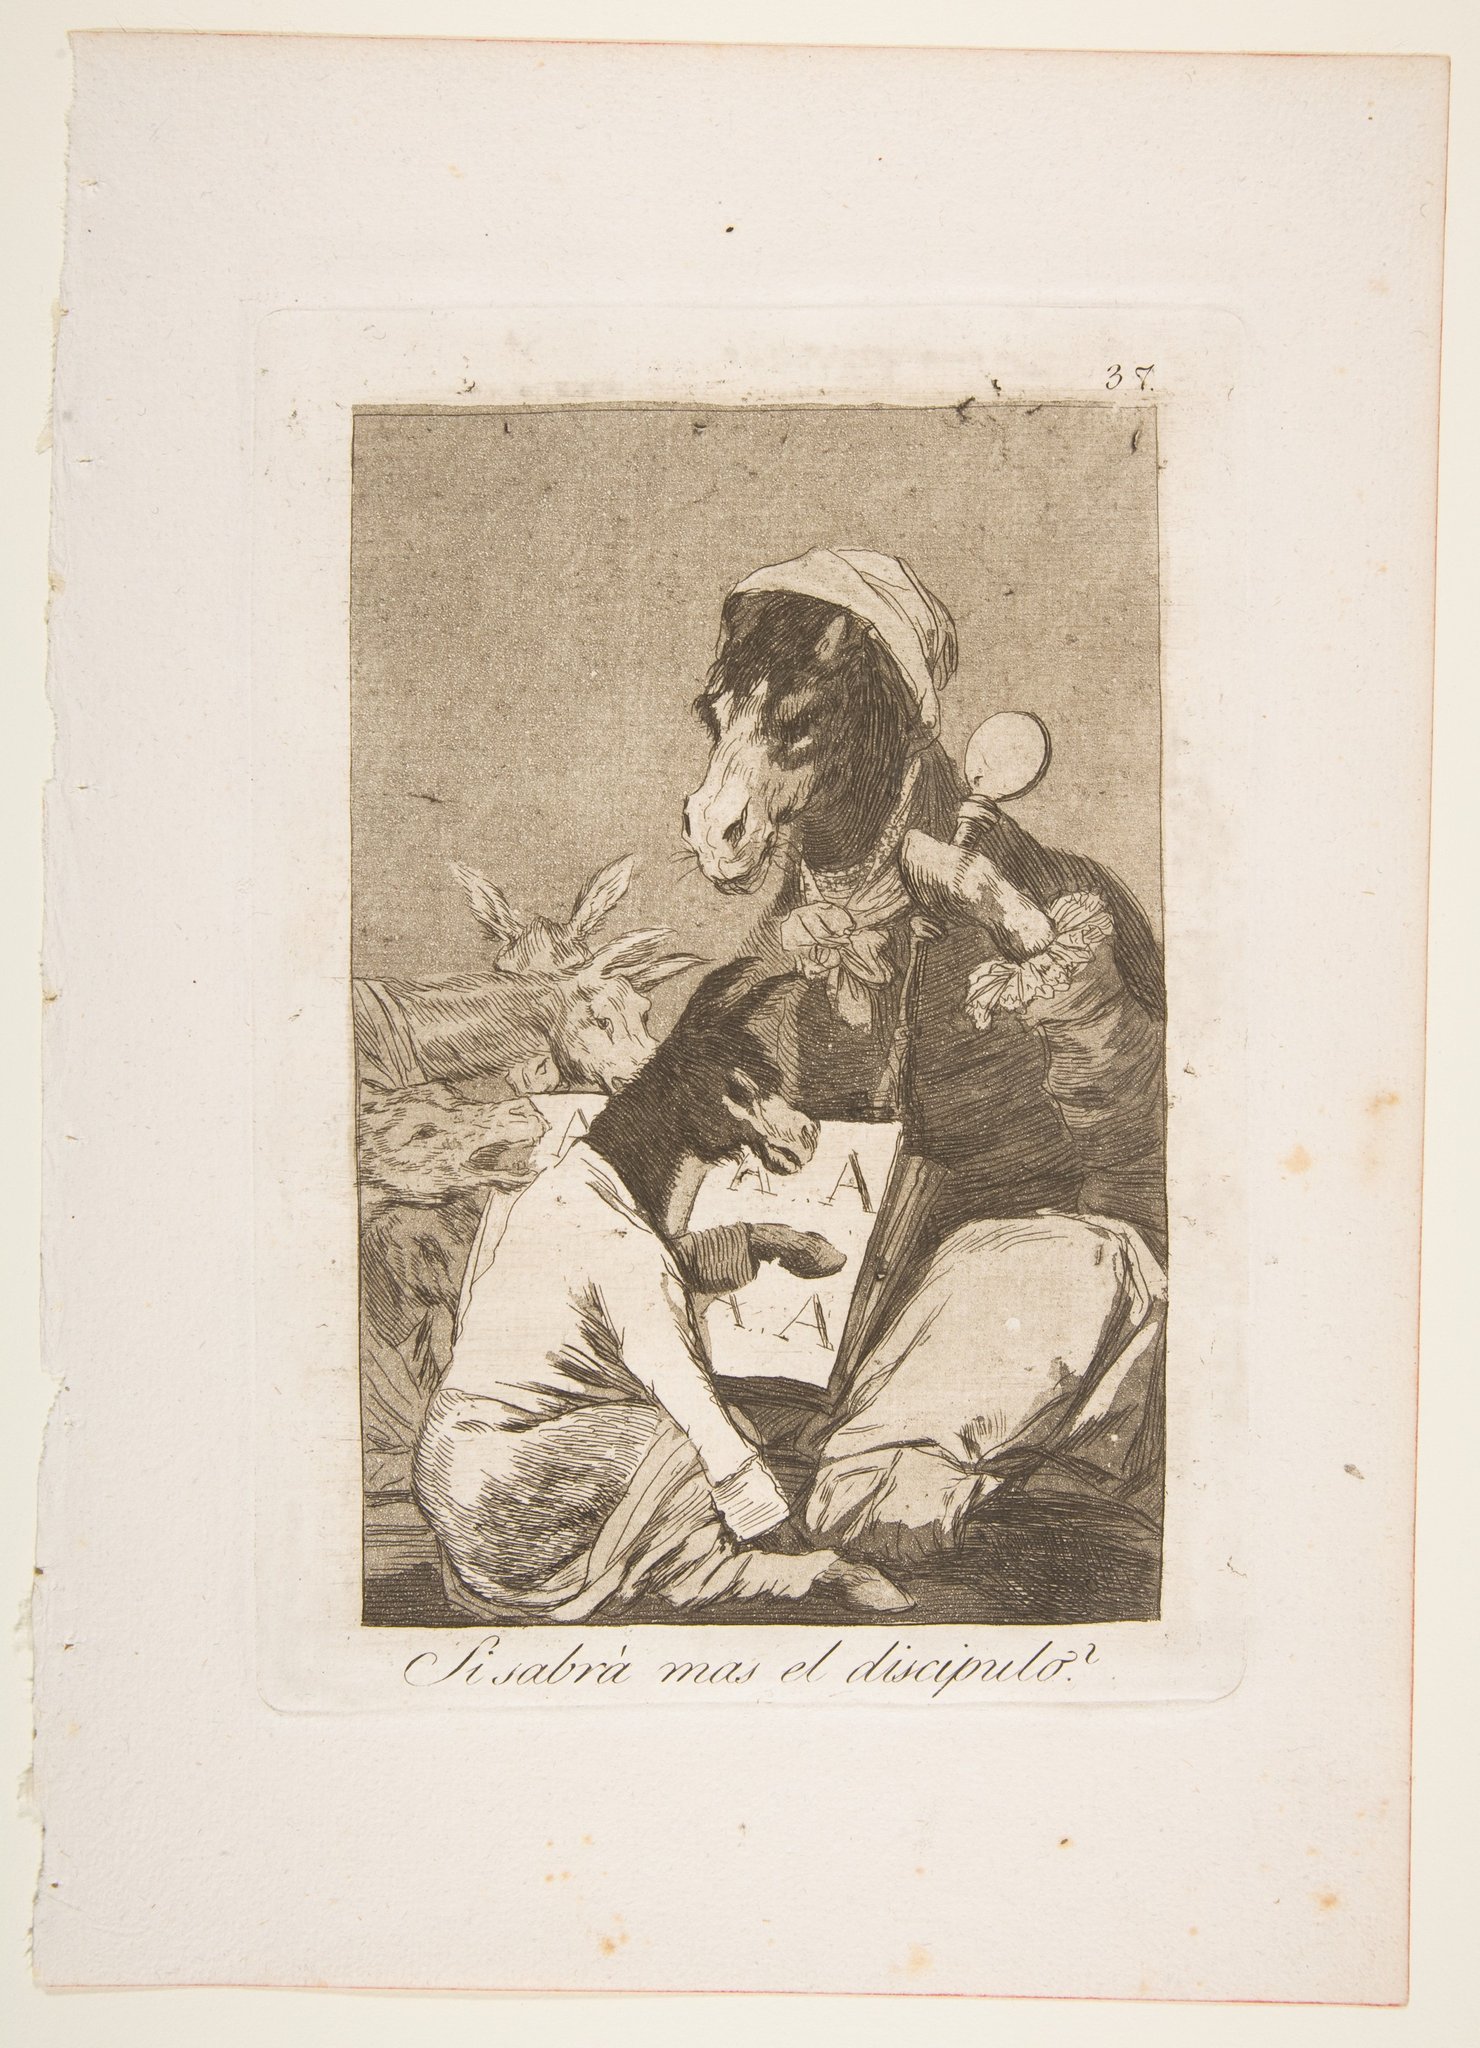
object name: print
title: Plate 37 from "Los Caprichos": Might not the pupil know more? (Si Sabrá mas el discipulo?)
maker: goya (francisco de goya y lucientes)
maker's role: artist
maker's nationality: spanish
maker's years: 1746-1828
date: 1799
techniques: aquatint, engraving, burnishing, etching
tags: animals,horses